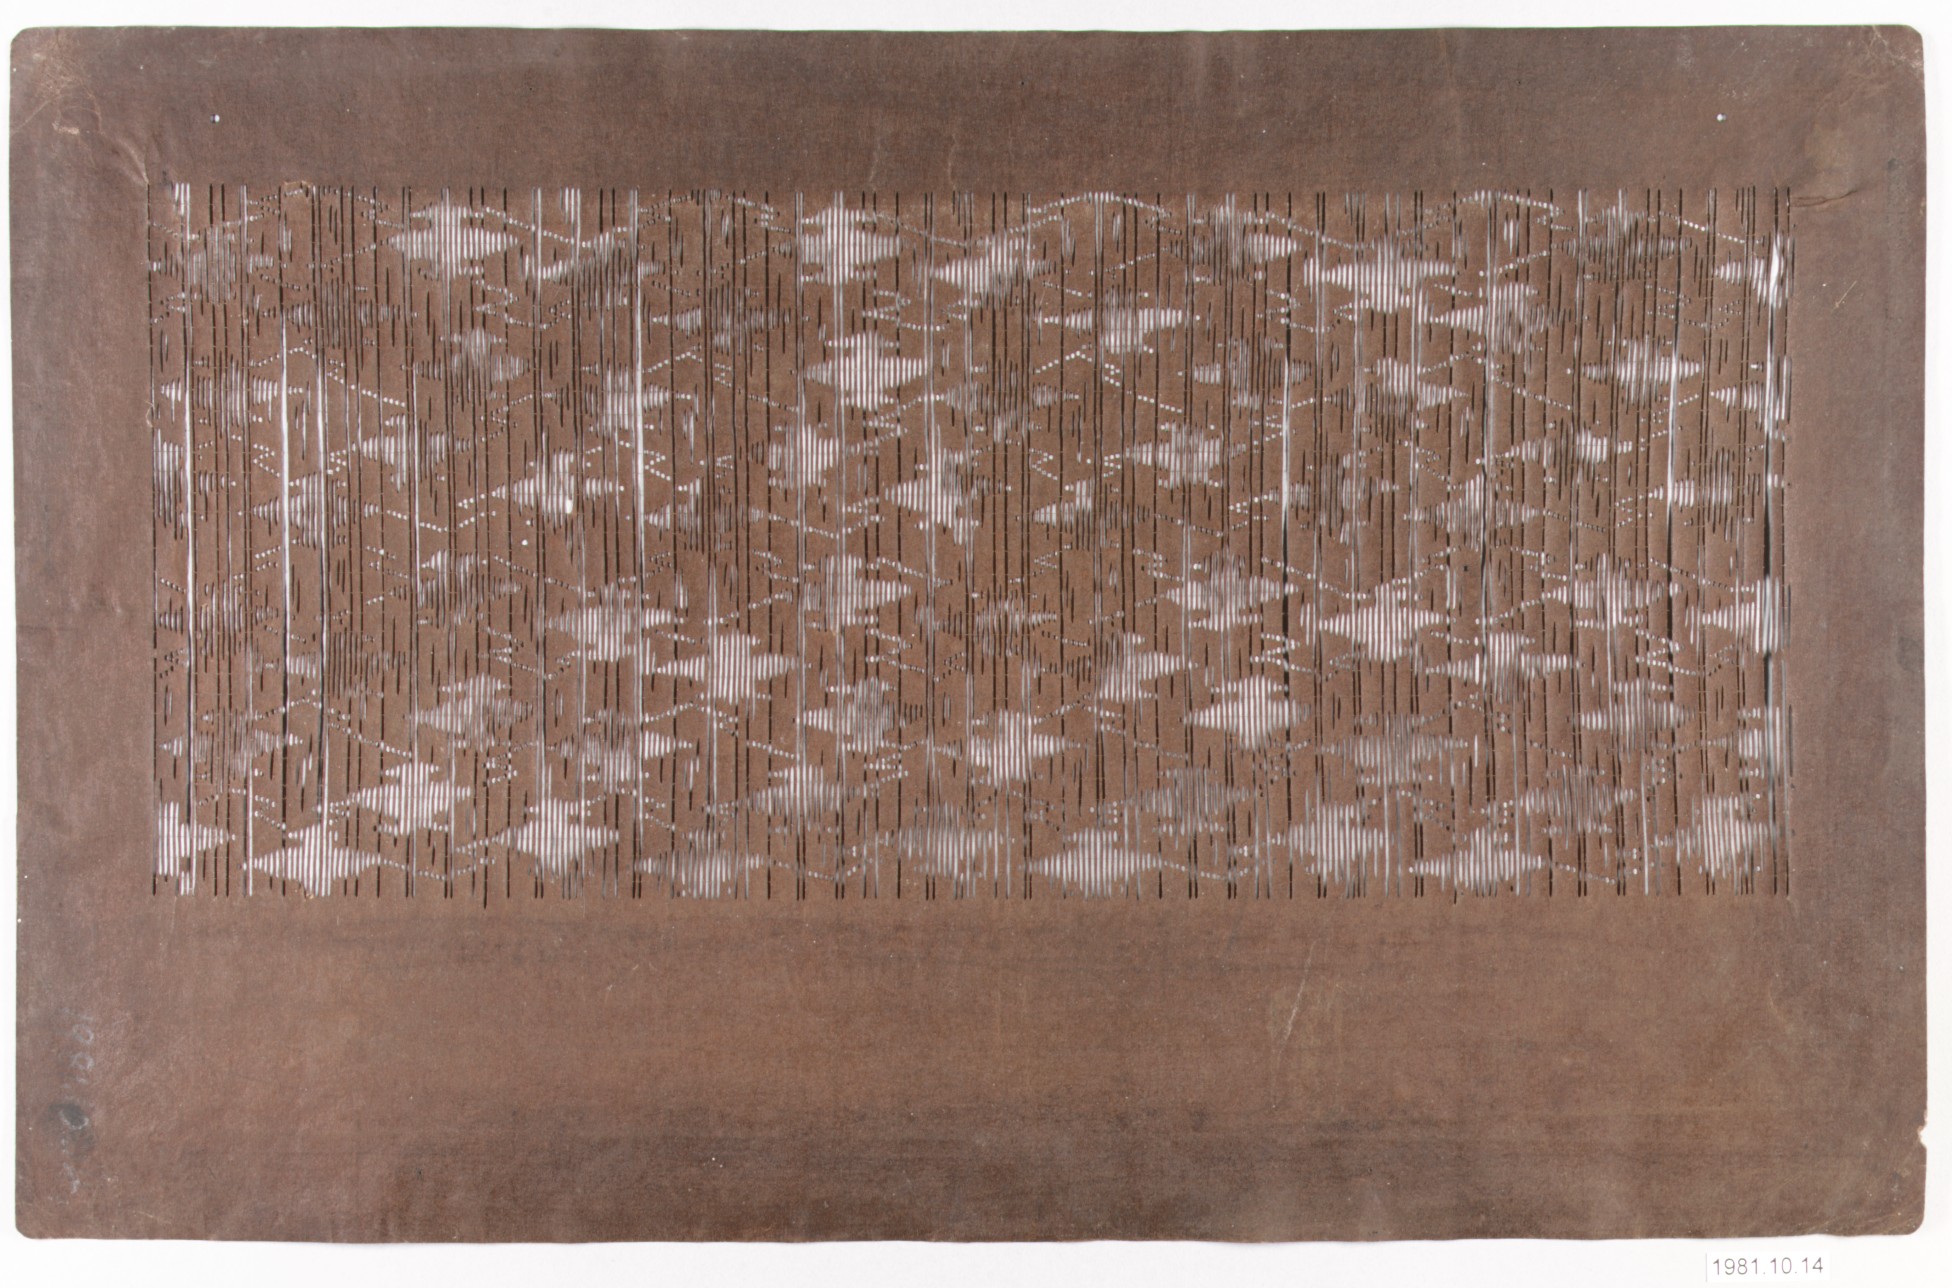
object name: stencil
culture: japanese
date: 1801-1900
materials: paper